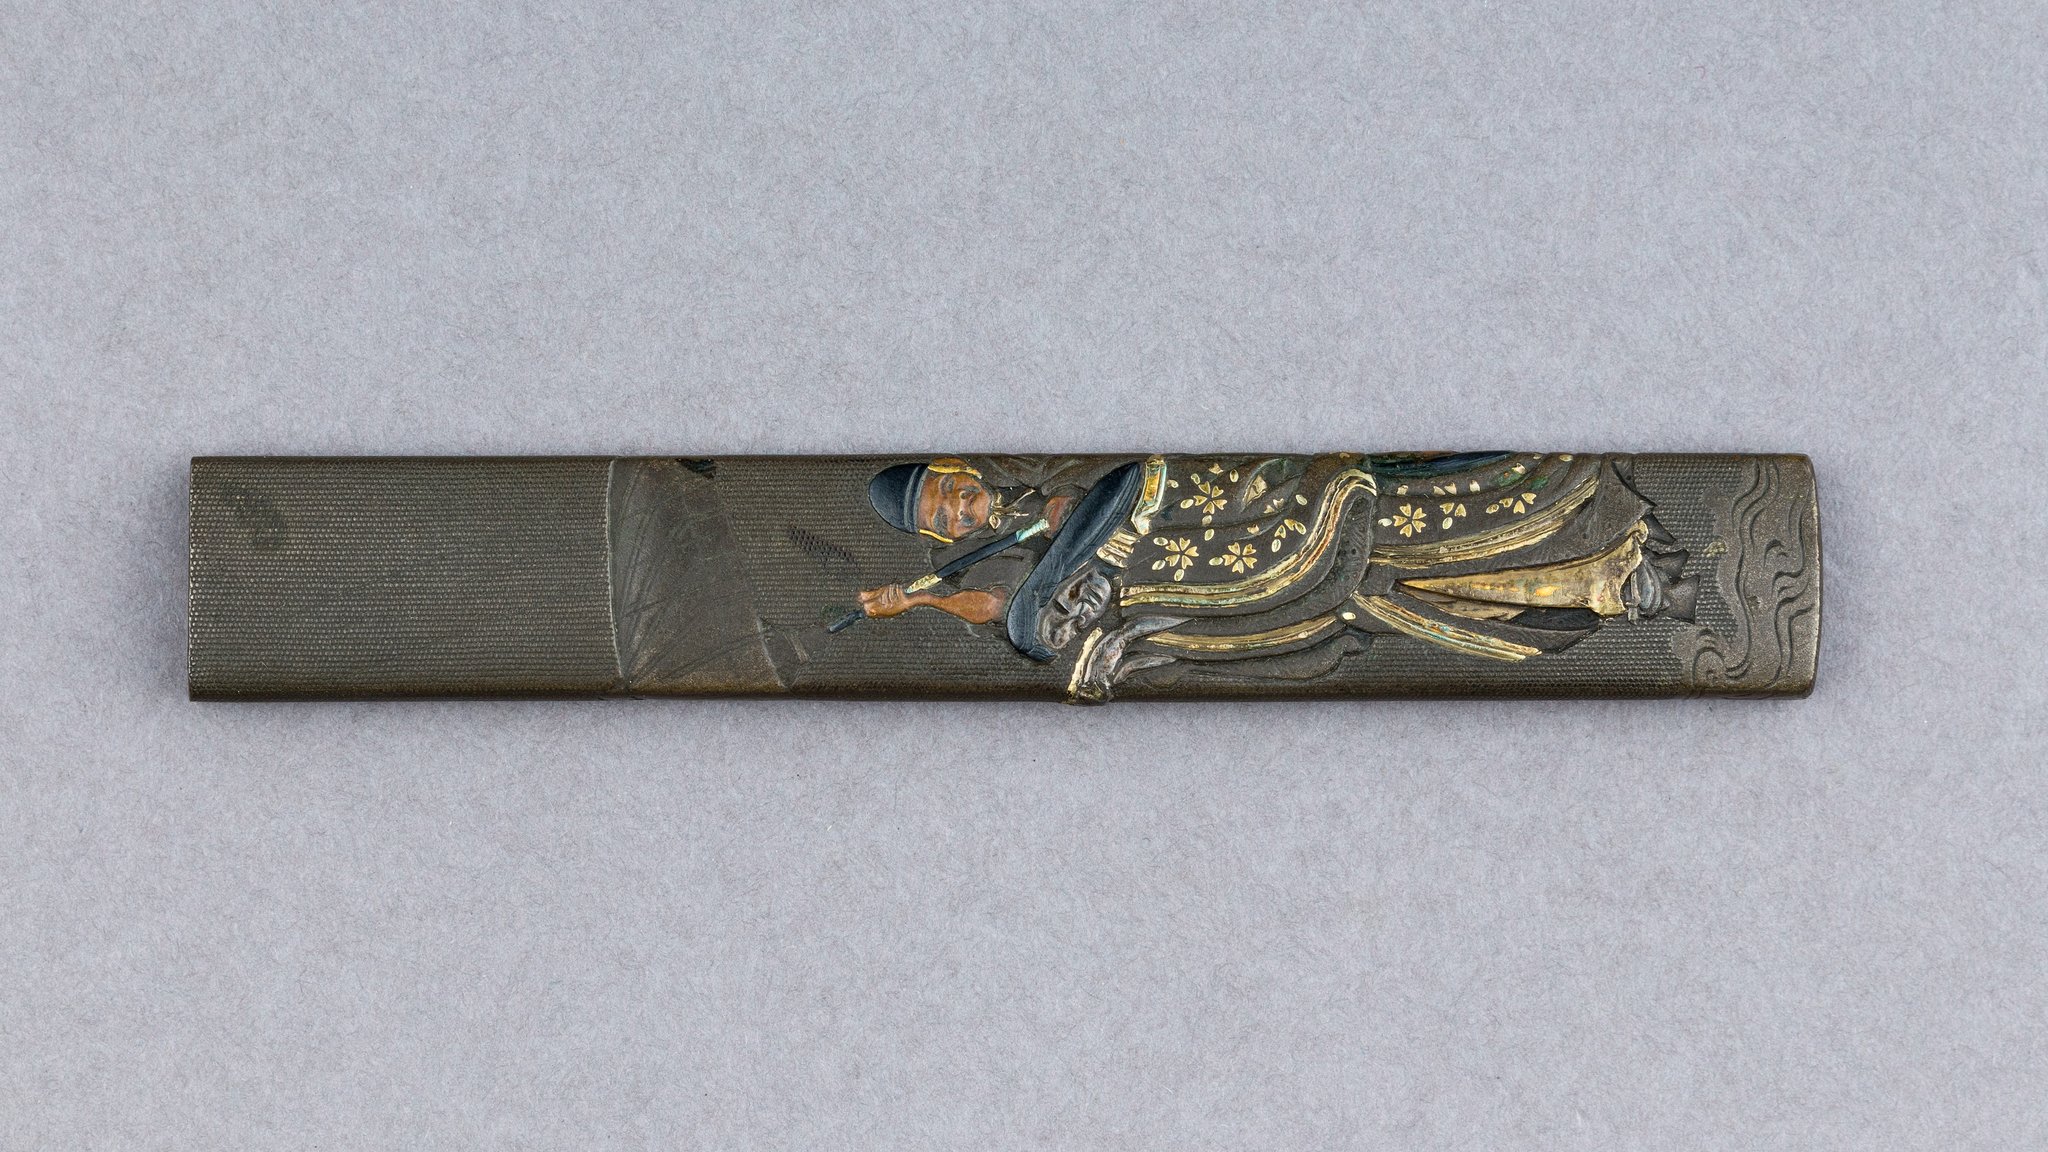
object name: knife handle kozuka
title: Knife Handle (Kozuka)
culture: japanese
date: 1615-1868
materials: copper, gold alloy, silver alloy, gold, silver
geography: japan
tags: human figures